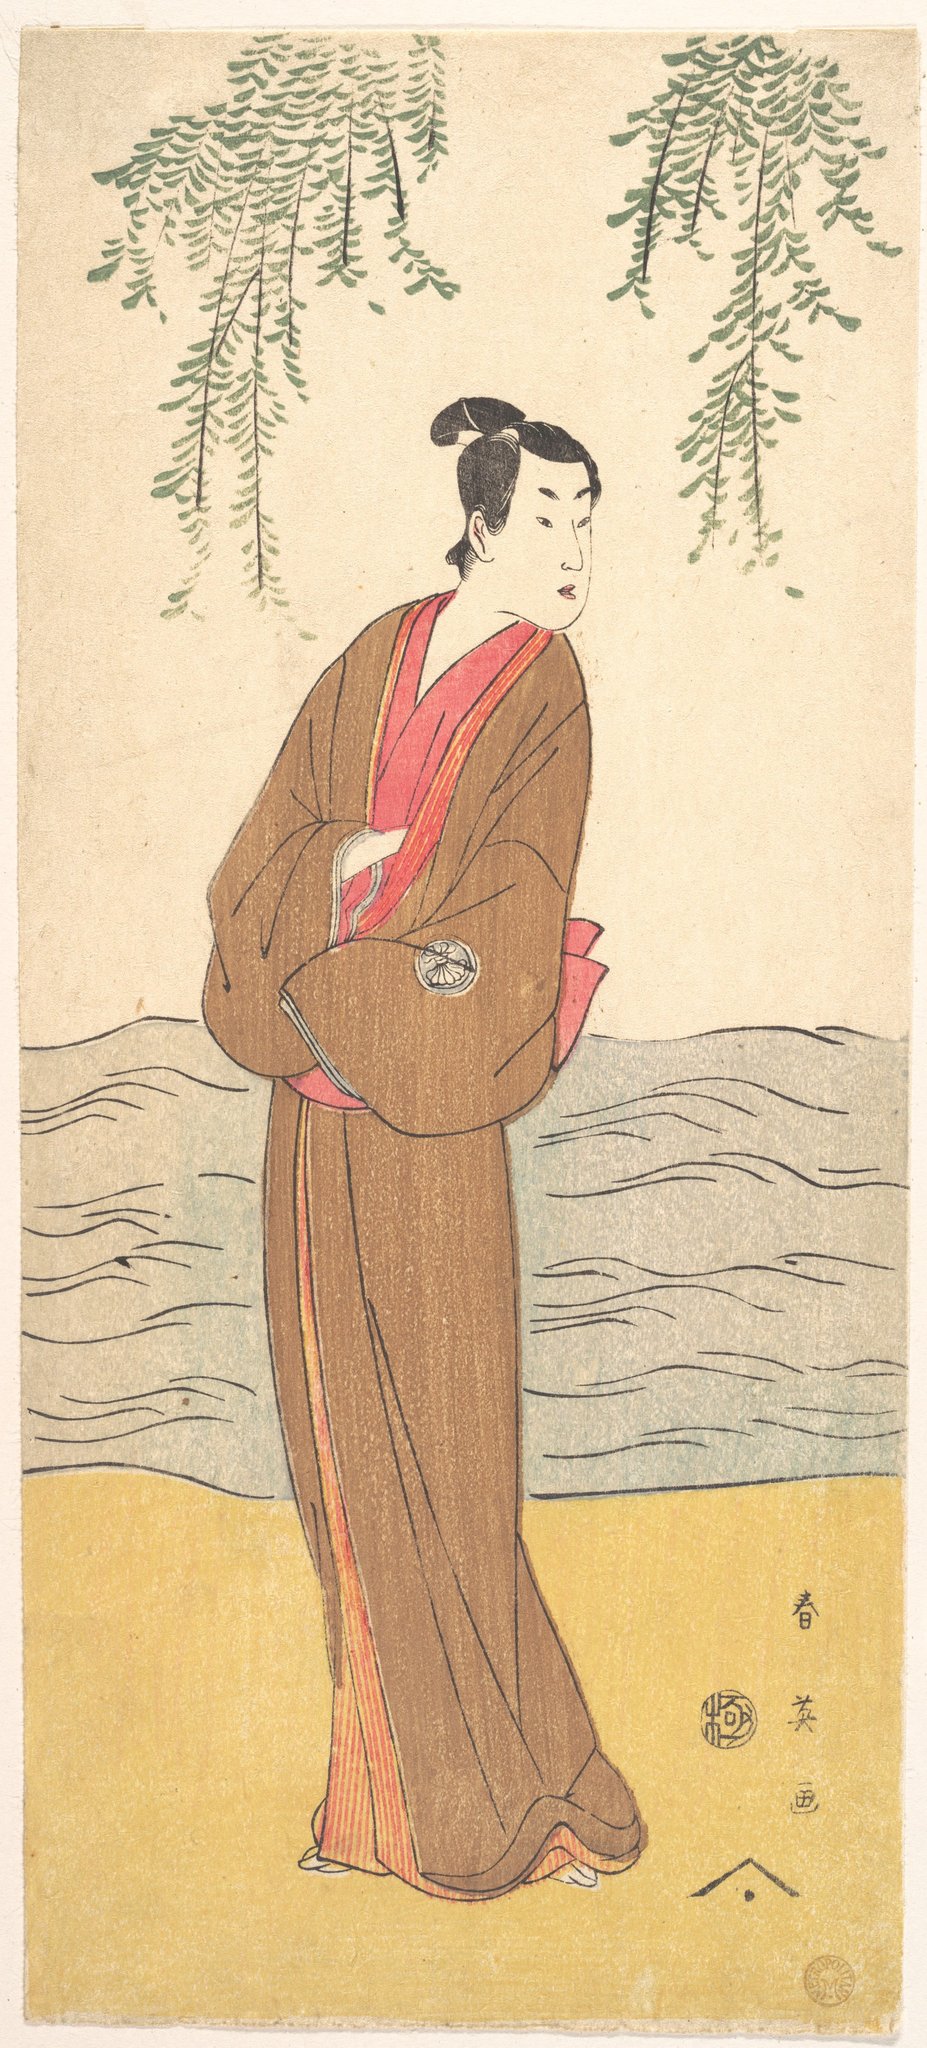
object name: print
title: The Third Segawa Kikunojo as Hisamatsu Standing on the Bank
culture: japanese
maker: katsukawa shun'ei 勝川春英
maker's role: artist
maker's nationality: japanese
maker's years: 1762-1819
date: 1795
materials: ink, paper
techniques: woodblock print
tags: men,actors